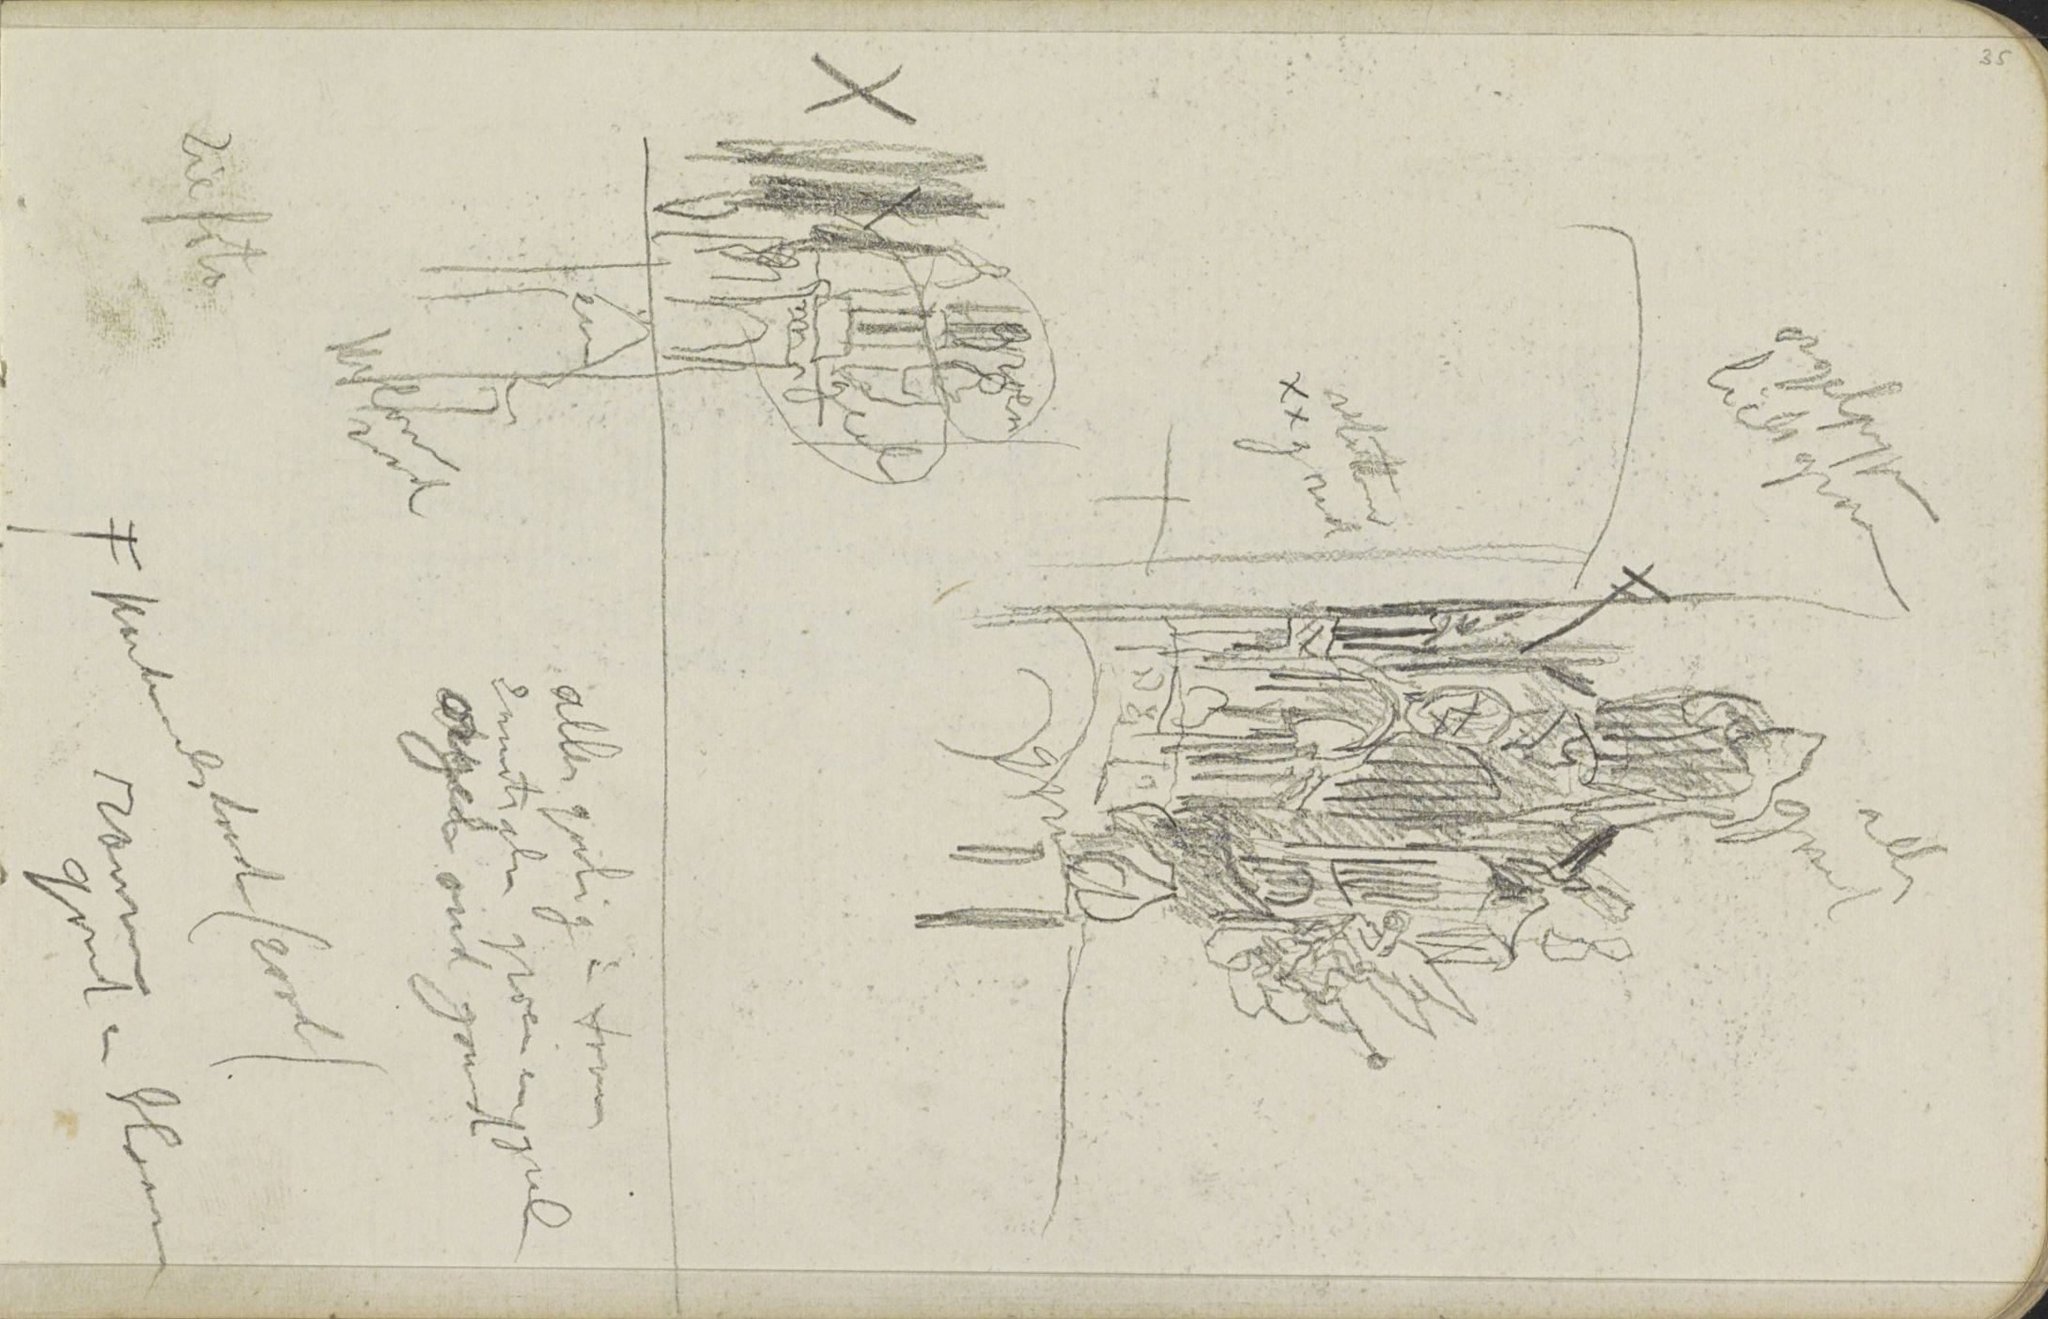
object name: sketchbook leaf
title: Orgel van de kathedraal van Toledo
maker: marius bauer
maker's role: draughtsman, print maker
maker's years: 1867-1932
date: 1902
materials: paper, pencil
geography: toledo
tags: church organ, interior of church, toledo cathedral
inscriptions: annotation: ‘zie foto’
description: Pagina 35 uit een schetsboek met 30 bladen.